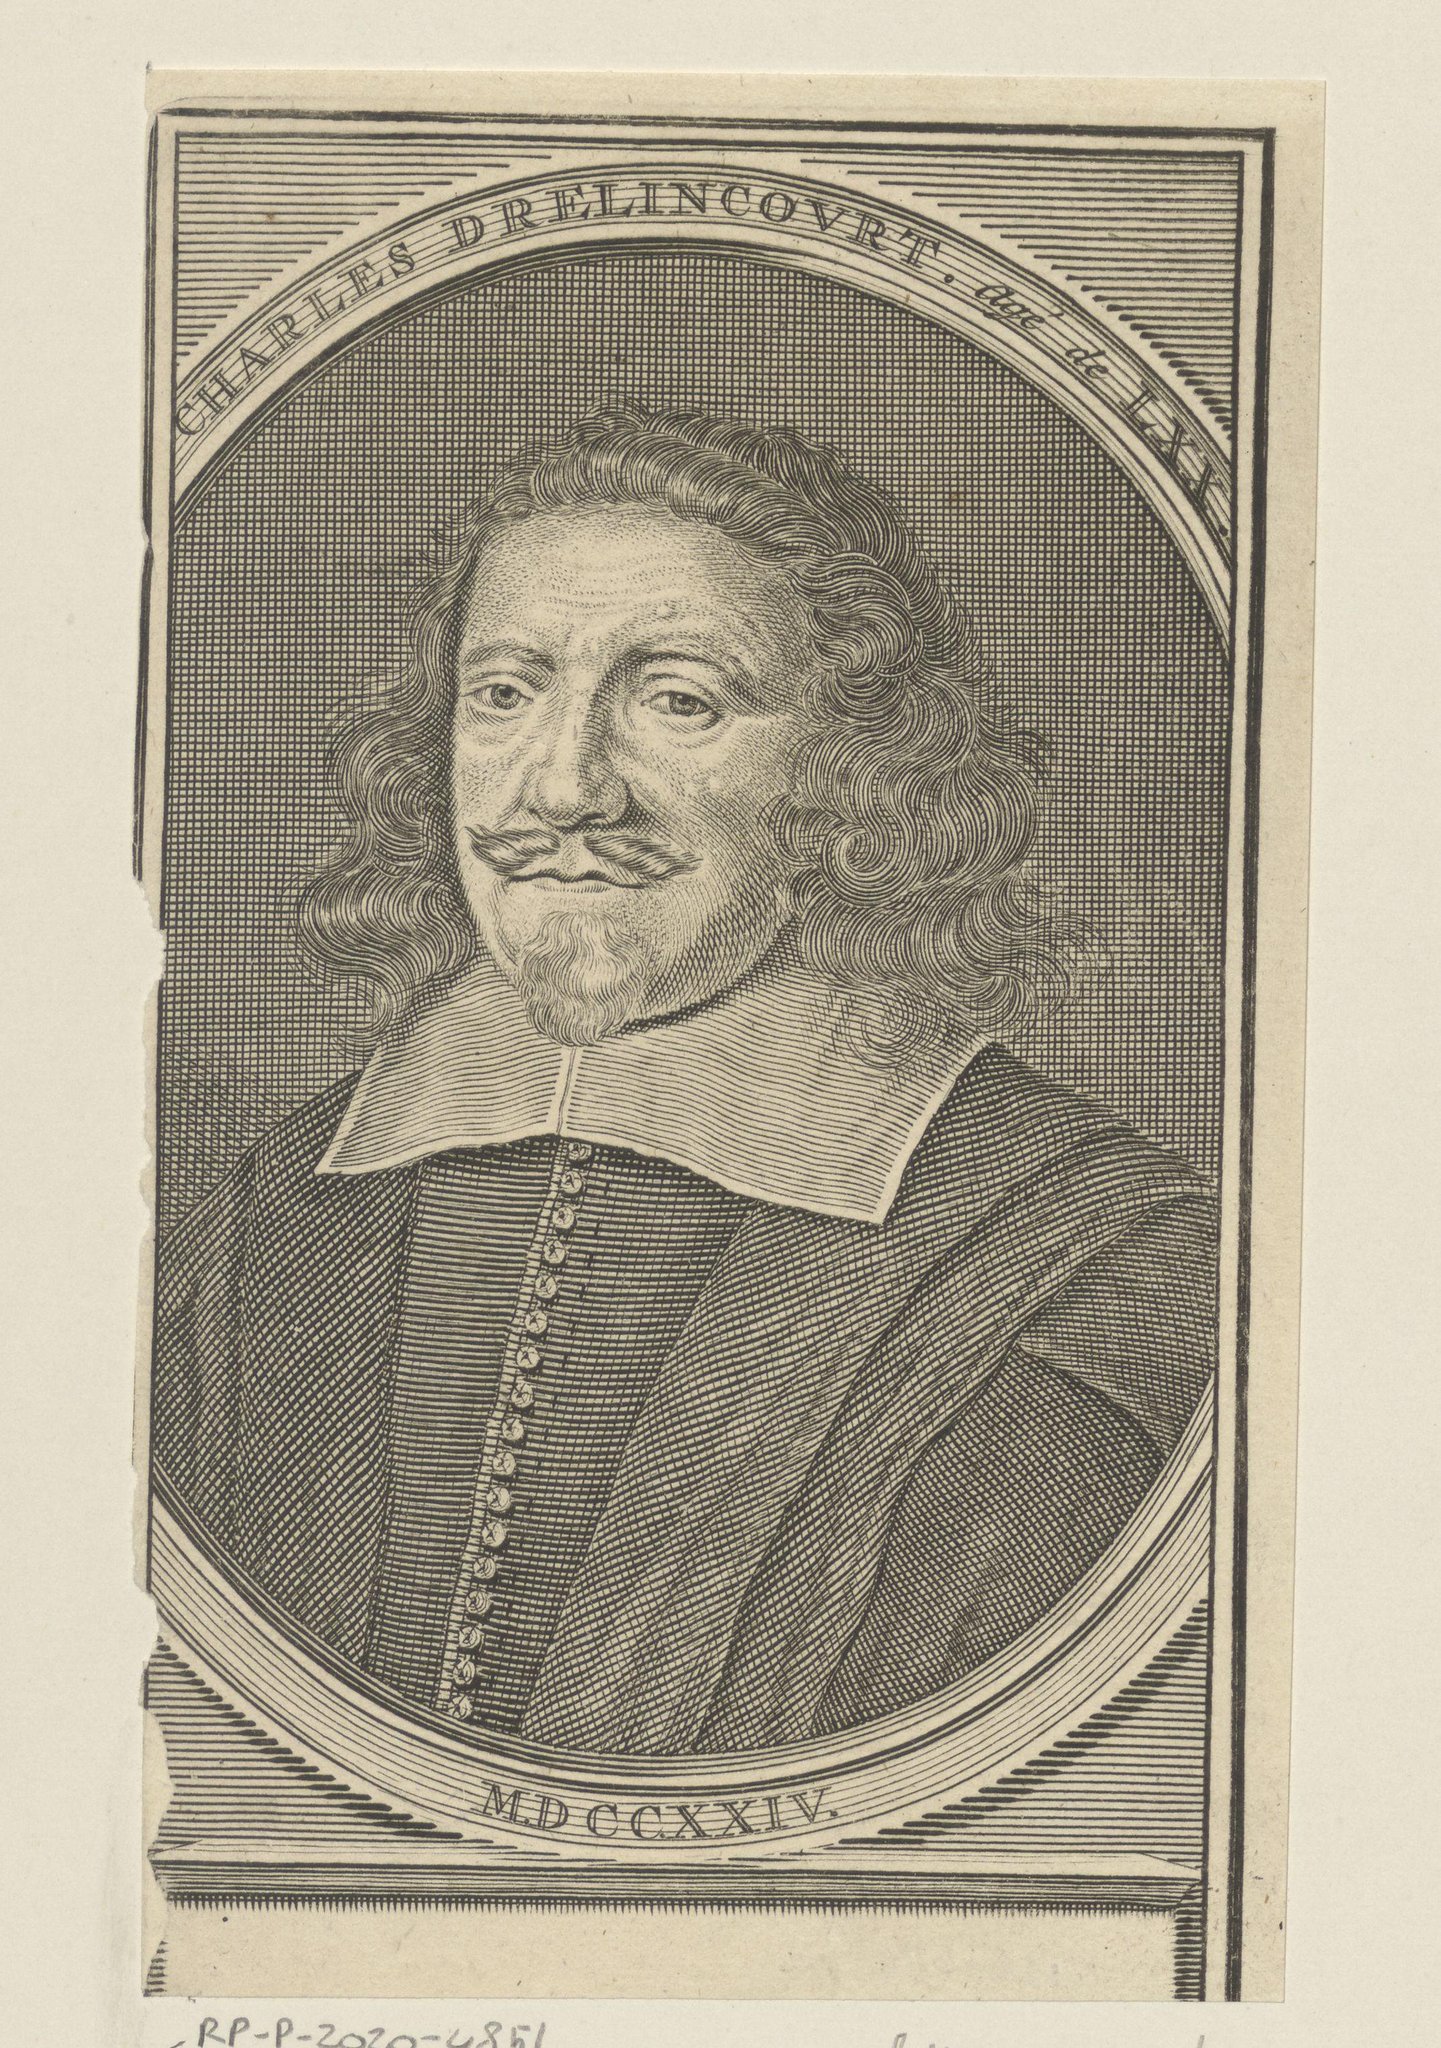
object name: print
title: Portret van Charles Drelincourt op 70-jarige leeftijd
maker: Anonymous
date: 1724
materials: paper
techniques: engraving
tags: theologian, historical persons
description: Prent mogelijk uit: Drelincourt, Charles. Les consolations de l'âme fidèle contre les frayeurs de la mort. Amsterdam: weduwe Jaques Desbordes, 1724, dl. 2.